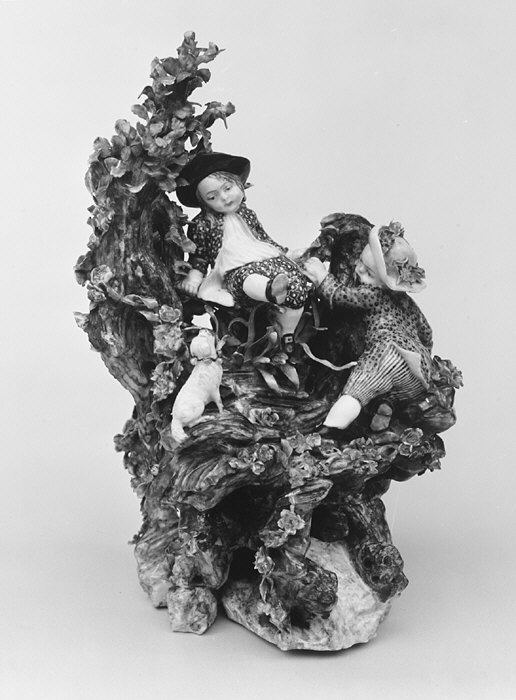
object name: group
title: The Swing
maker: tournai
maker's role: factory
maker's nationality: belgian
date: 1760-1770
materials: soft paste porcelain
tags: children,dogs